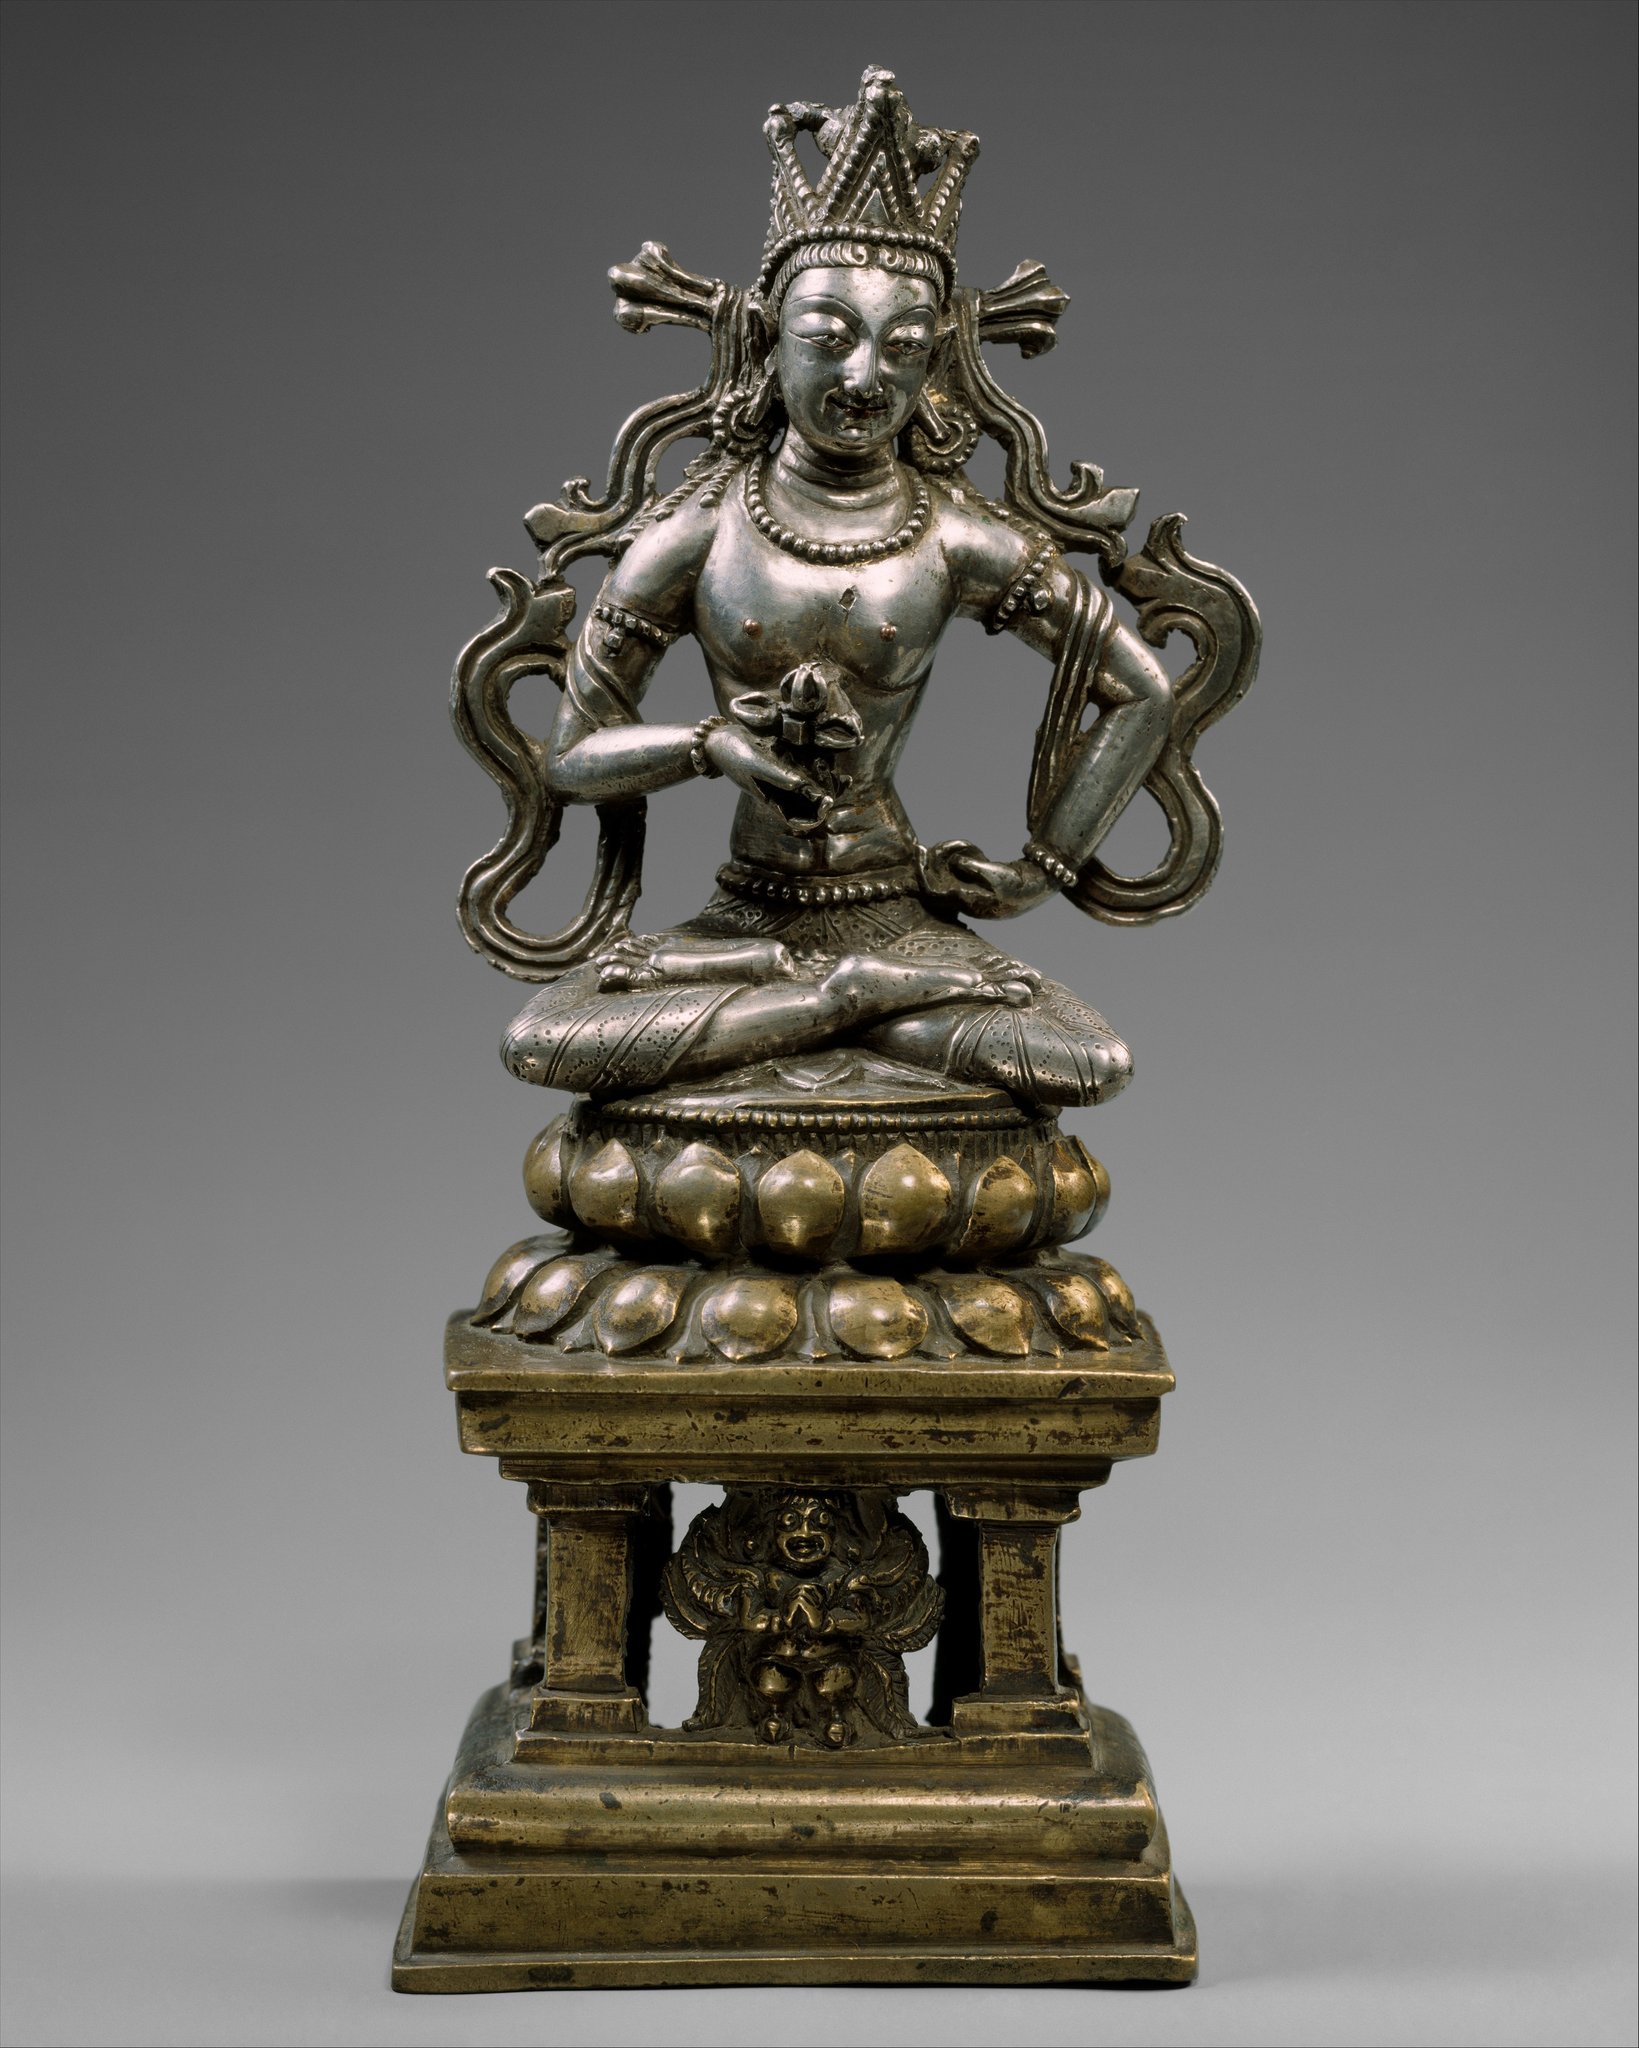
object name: figure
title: Amoghasiddhi, the Transcendent Buddha of the North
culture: tibetan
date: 967-1033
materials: bronze, copper, gold foil, silver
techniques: inlay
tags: lotuses,buddhism,amoghasiddhi